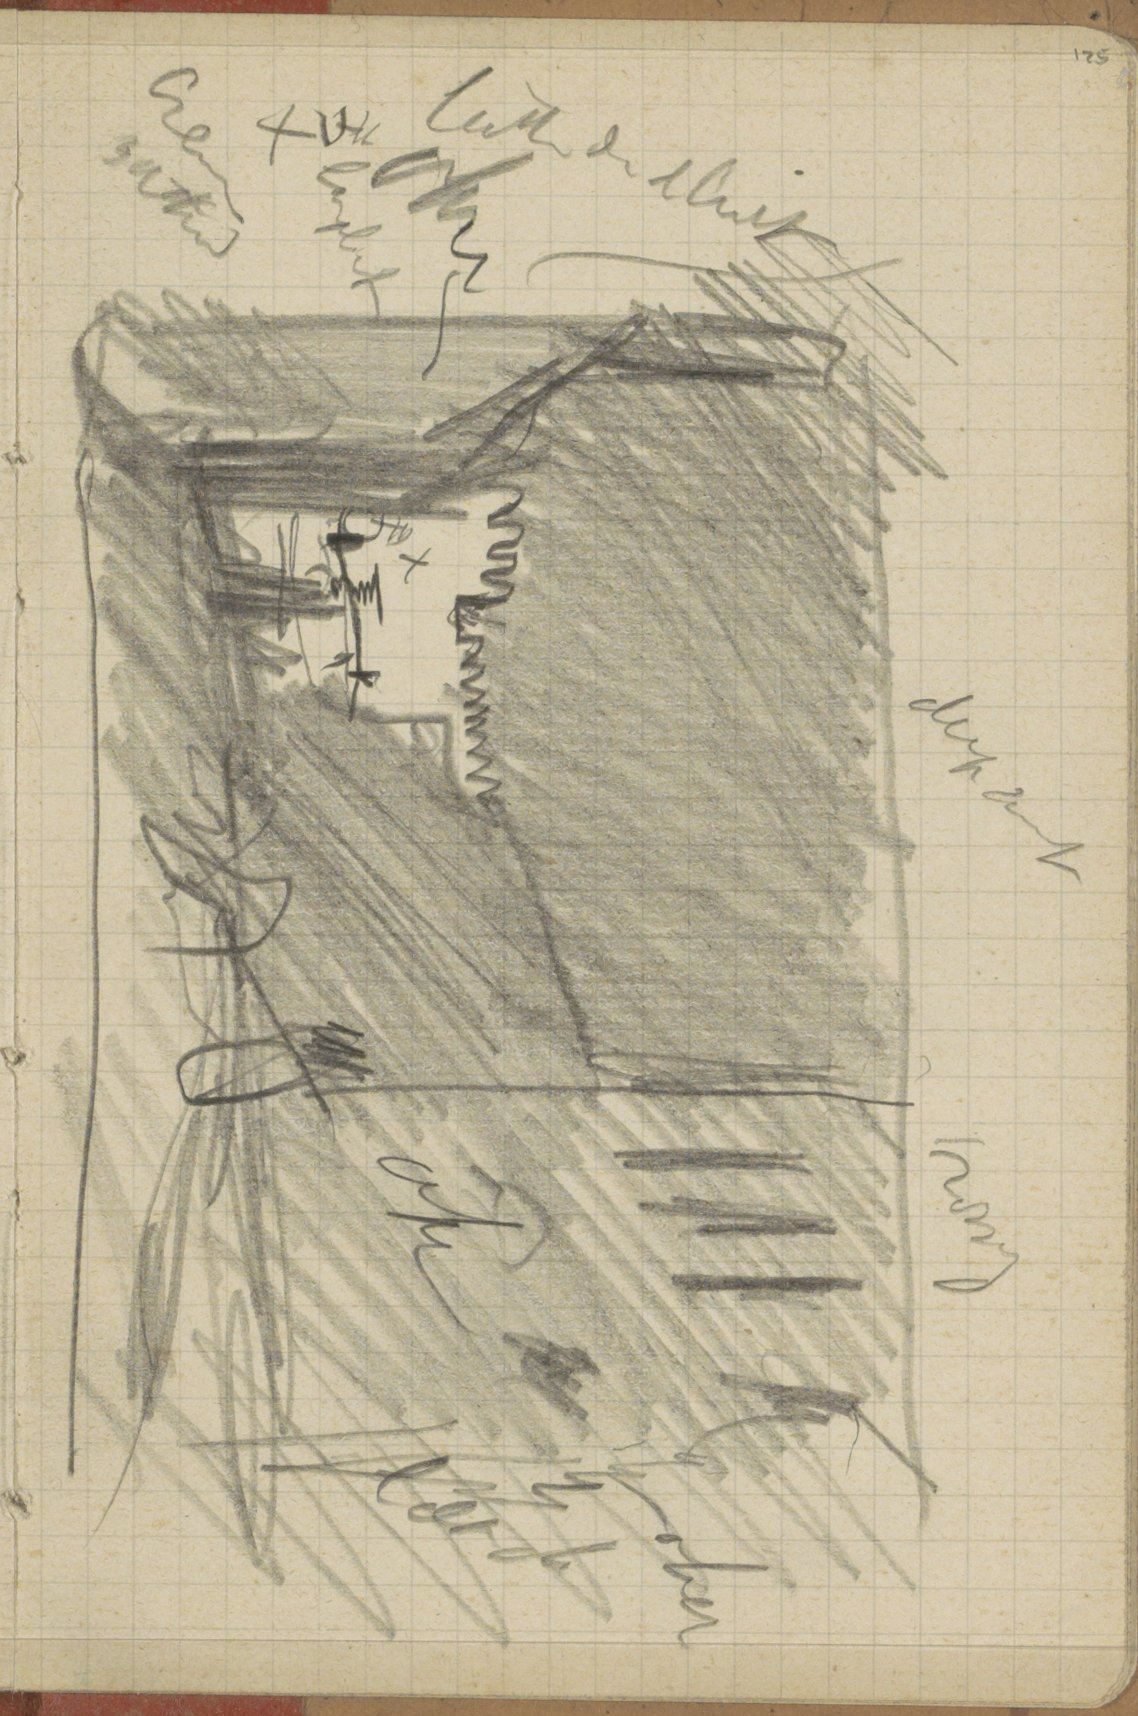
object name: sketchbook leaf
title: Straatgezicht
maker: marius bauer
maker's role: draughtsman, print maker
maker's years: 1867-1932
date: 1909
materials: pencil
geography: tunisia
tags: walls ~ fortified city, street (+ city(-scape) with figures, staffage)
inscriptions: kleurnotitie, handgeschreven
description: Op de achtergrond is een deel van een muur, mogelijk de stadsmuur van Kairouan, te zien. Pagina 125 uit een schetsboek met 67 bladen.